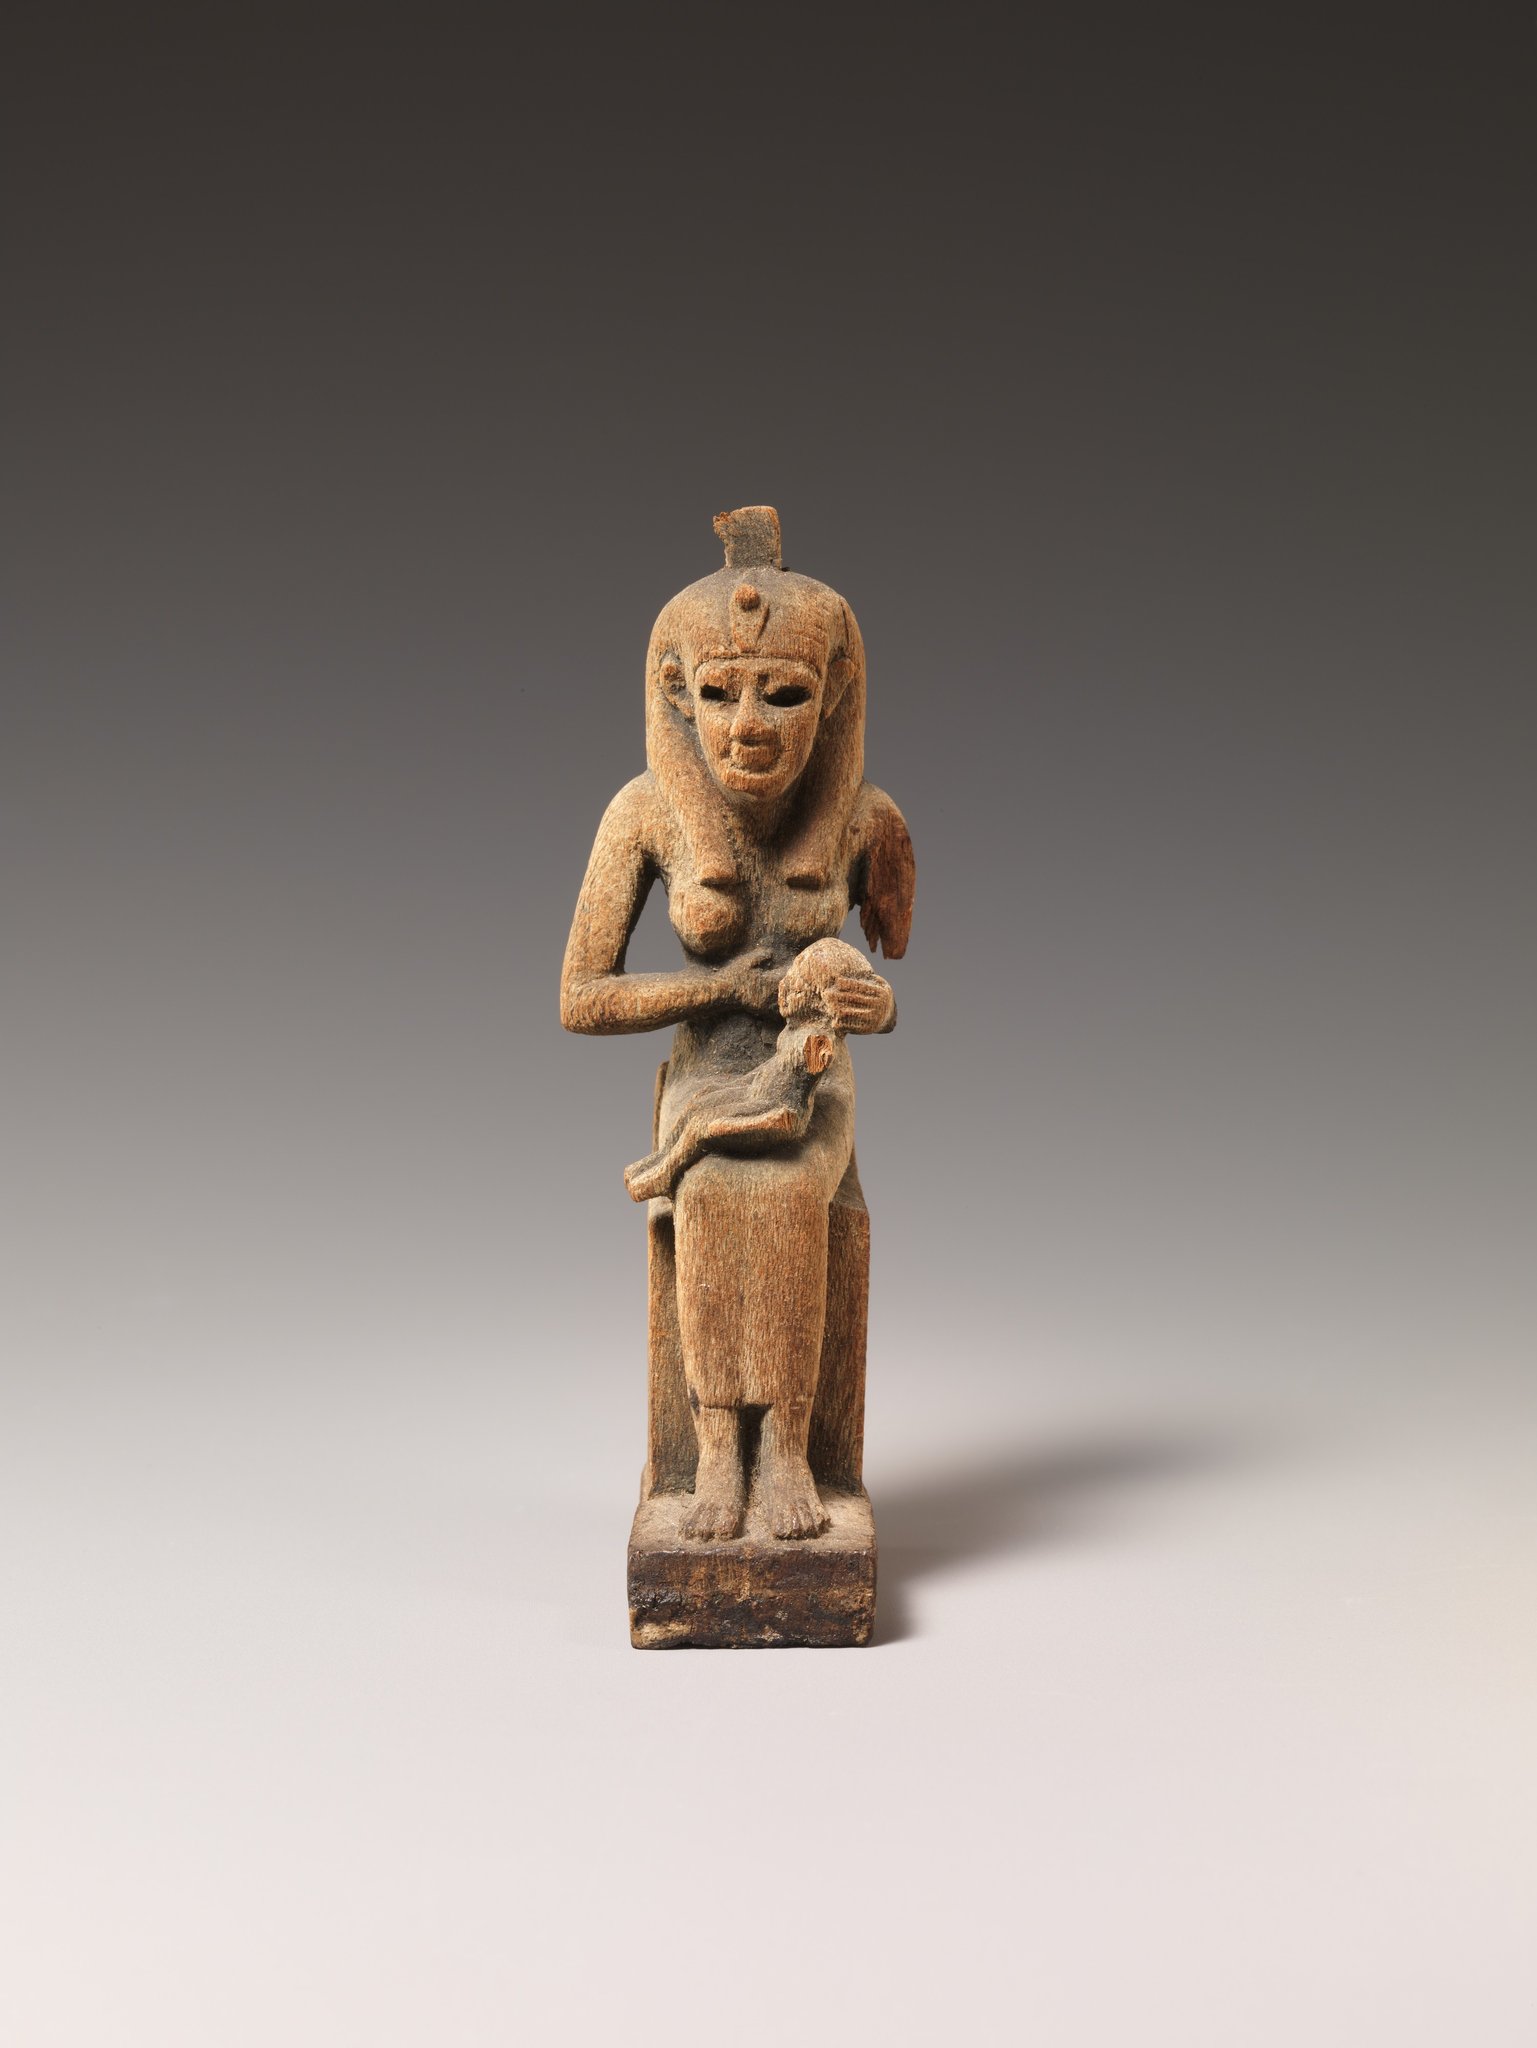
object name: statuette, isi, horus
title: Isis and Horus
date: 664-630 BCE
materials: wood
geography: egypt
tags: horus,isis